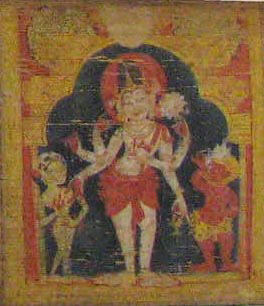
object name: folio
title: Folio from a Buddhist Manuscript of Pancavimsatisahasrika Prajnaparamita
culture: indian, bengal or bangladesh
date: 1090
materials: leaf, watercolor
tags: buddhism